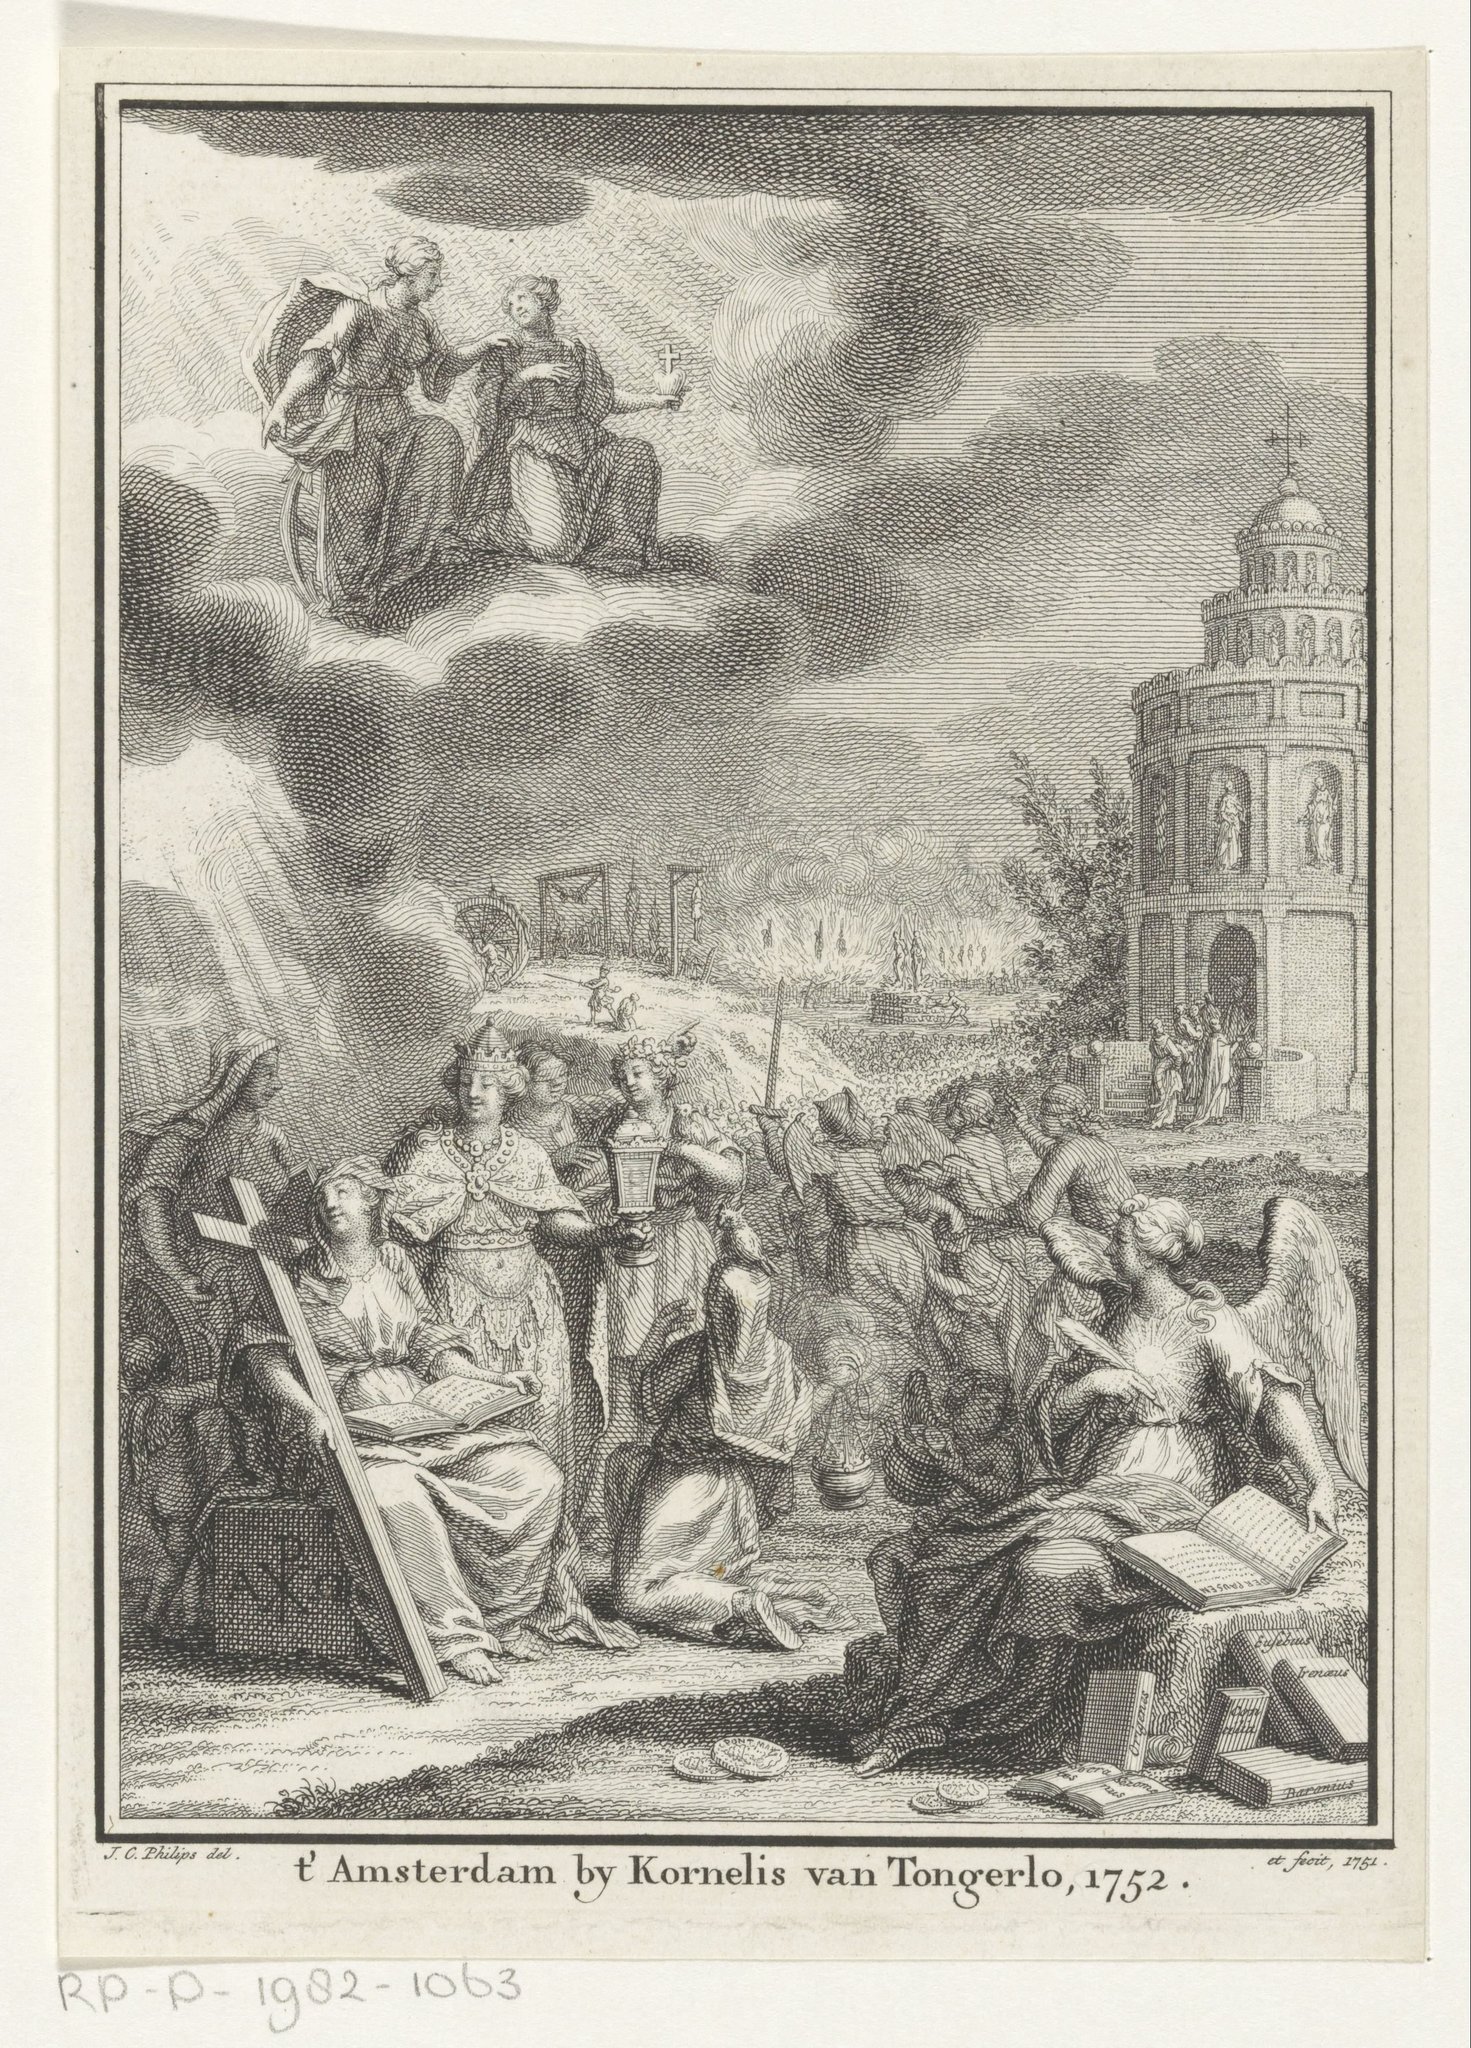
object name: titelblad, titelpagina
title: Allegorische voorstelling met Geloof, gekroonde vrouw en Geschiedenis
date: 1751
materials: paper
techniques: etching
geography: amsterdam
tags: faith, 'fides'; 'fede', 'fede catholica', 'fede christiana', 'fede christiana catholica' (ripa) ~ one of the three theological virtues, hope, 'spes'; 'speranza divina e certa' (ripa) ~ one of the three theological virtues, 'superstitione' (ripa), 'historia'; 'historia' (ripa)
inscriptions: collector's mark: Lugt 2760, collector's mark: Lugt 2228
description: De personificatie van het geloof met kruis en het evangelie zit naast een gekroonde vrouw met een monstrans in de hand. Bij hen zit Bijgeloof op de rug gezien, met uil op het hoofd en een wierookvat in de hand. Rechts schrijft Geschiedenis de historie van de pausen. In de achtergrond rechts een rond kerkgebouw, links worden christenen gemarteld en ter dood gebracht. Geloof wordt vanaf een wolk beschenen door Hoop met anker en een vrouw met hart met kruis in de hand.